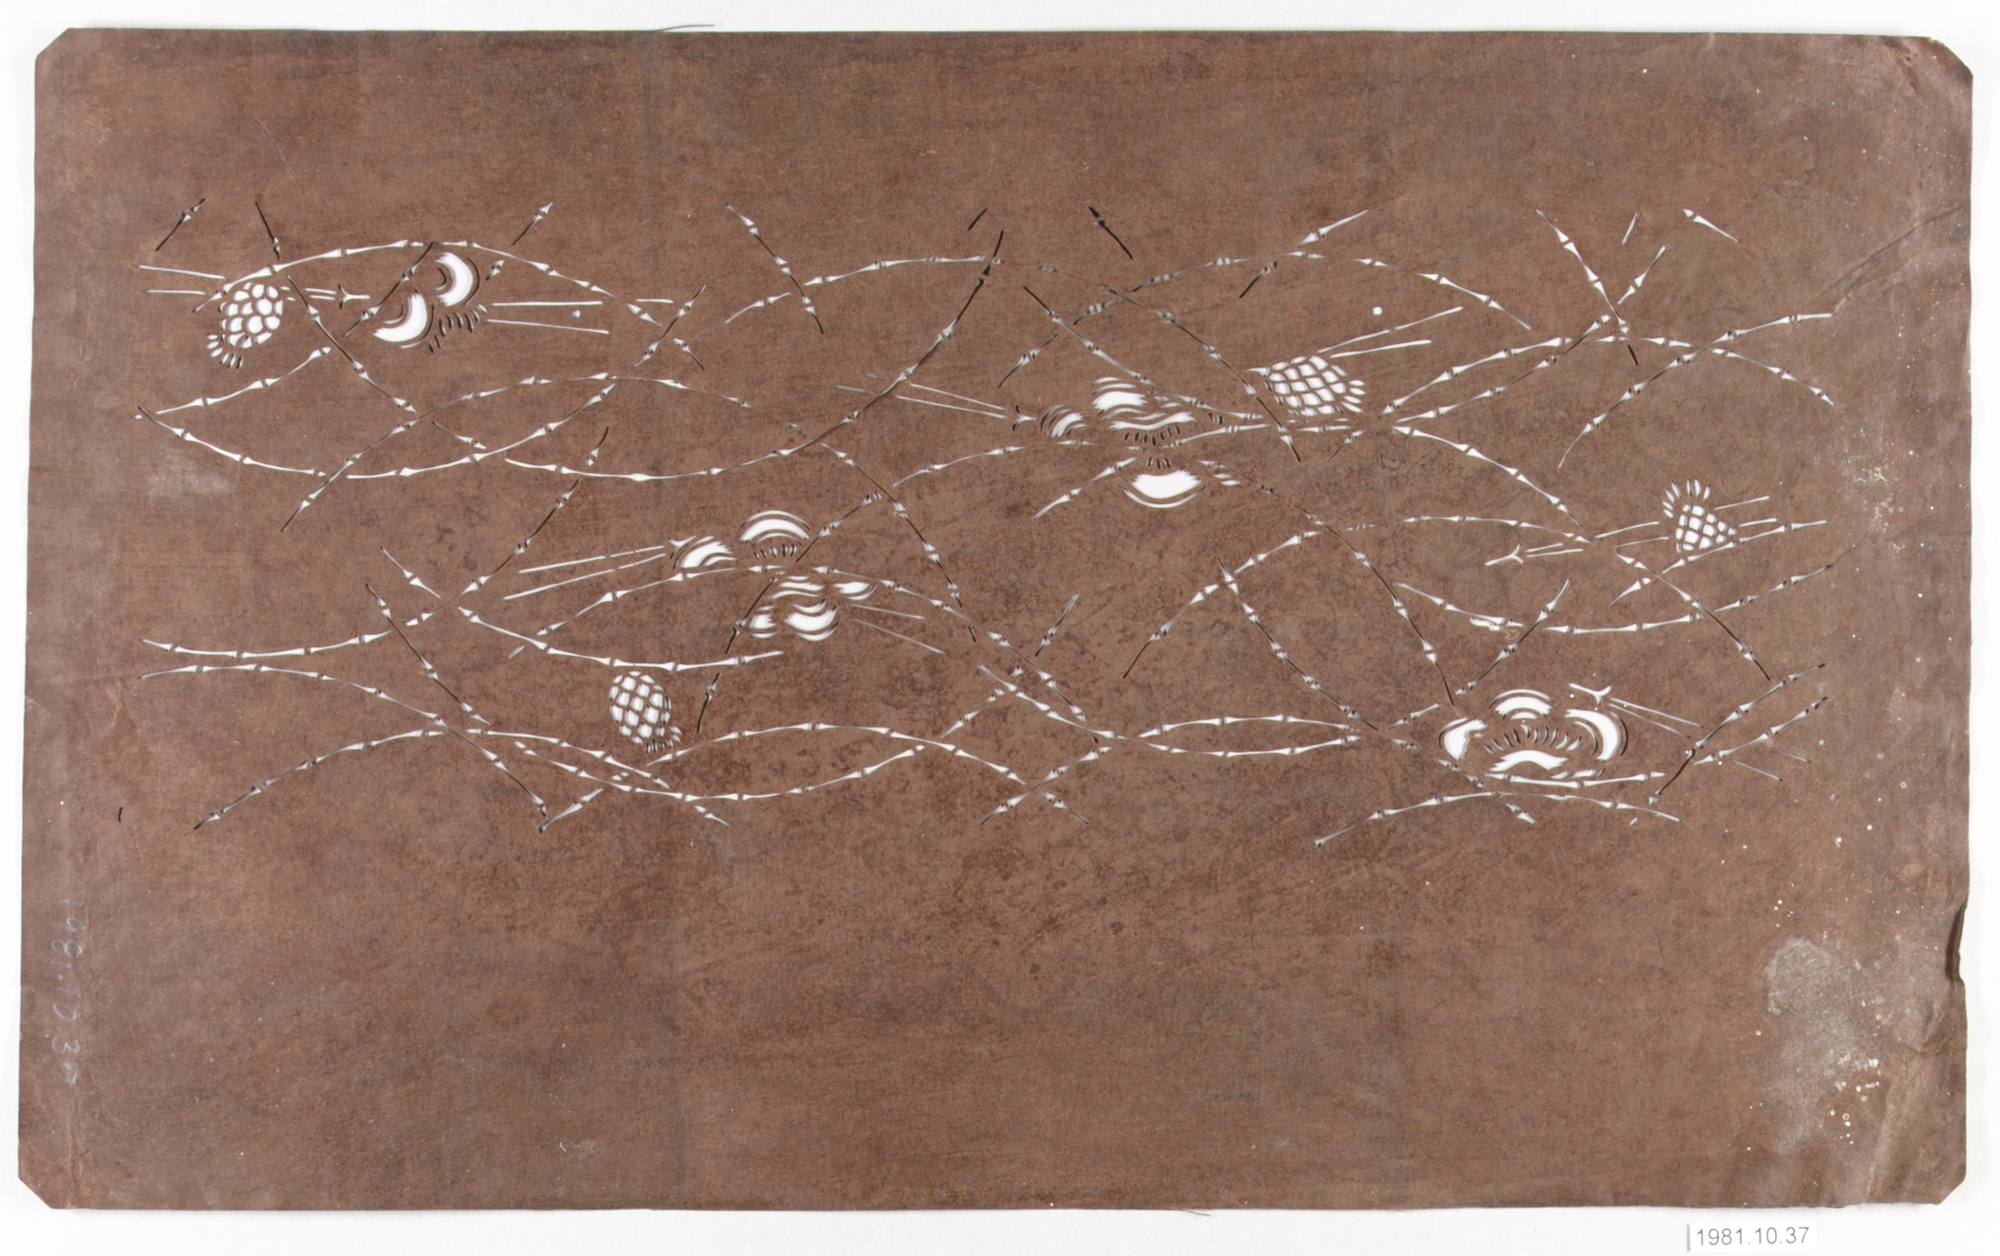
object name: stencil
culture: japanese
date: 1801-1900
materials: paper